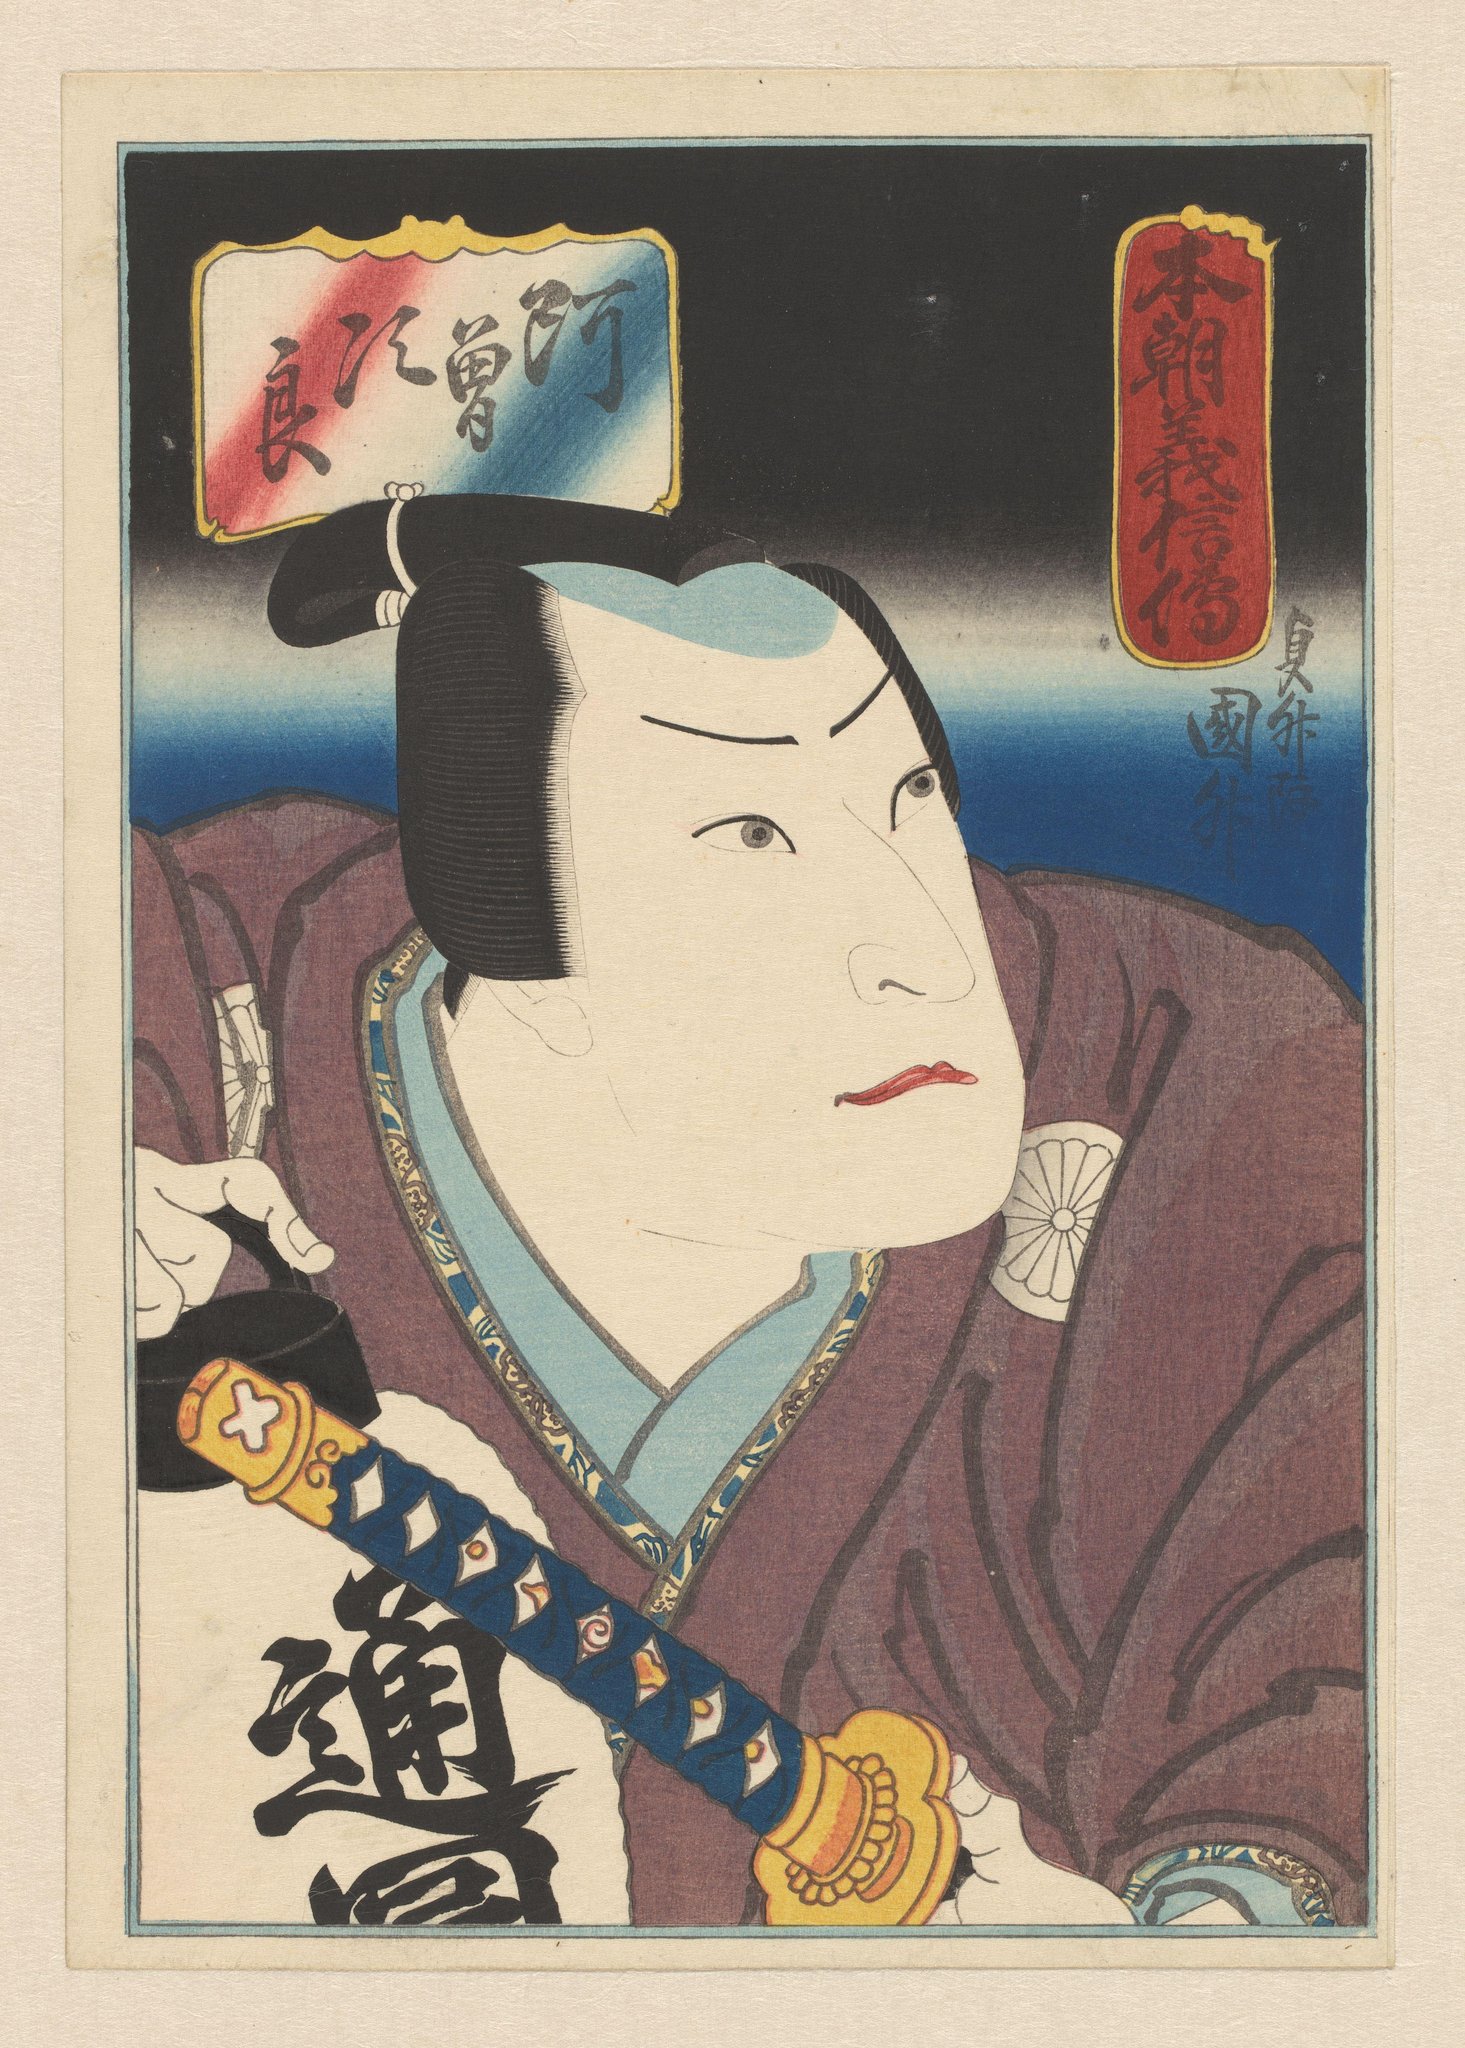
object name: print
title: Danshichi Kurobei, ten voeten uit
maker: utagawa sadamasu (ii)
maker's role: print maker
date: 1807-1849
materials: paper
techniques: woodcut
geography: osaka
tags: hacking and thrusting weapons: sword, portrait of actor, actress, lantern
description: Toneelspeler Nakamura Tamashichi in de rol van Danshichi Kurobei, in het toneelstuk ‘Natsumatsuri Naniwa kagami’, opgevoerd in de zevende maand van 1849 in het Kado Theater. De tekst rechts is afkomstig van leden van een acteursfanclub, de tekst links is door Ichimaru.